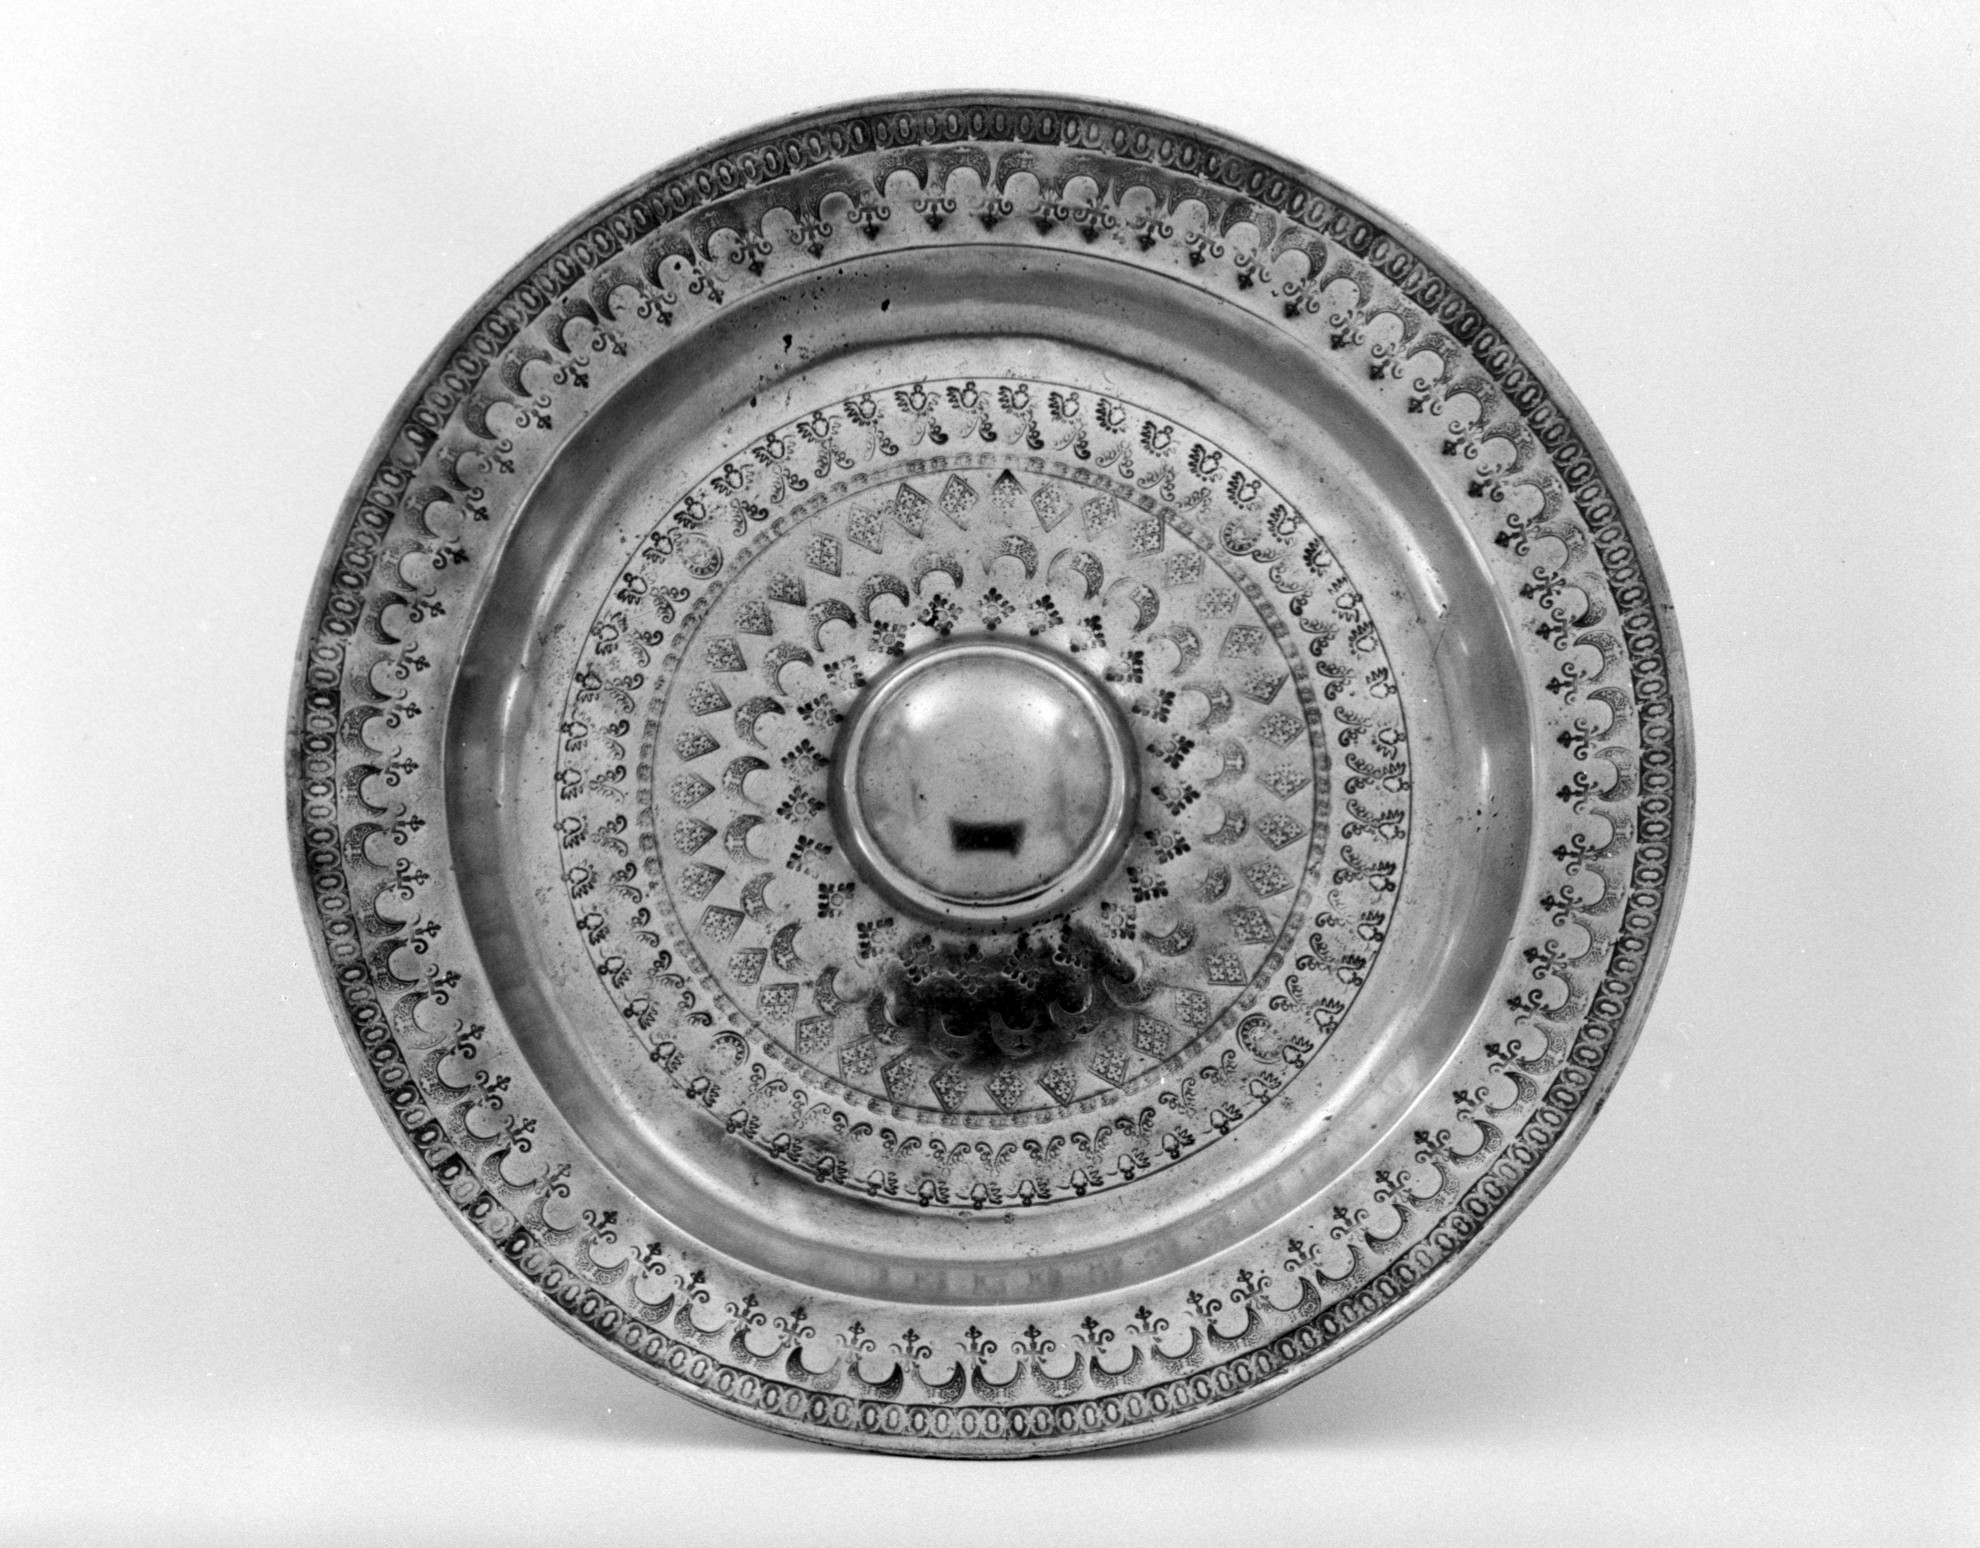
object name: rosewater dish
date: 1601-1633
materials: pewter